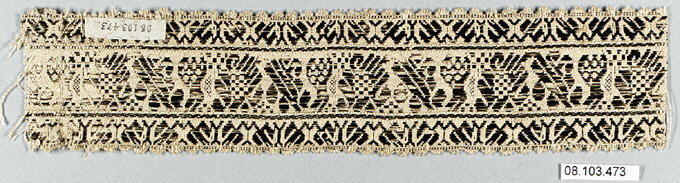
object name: galloon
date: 1801-1900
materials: silk